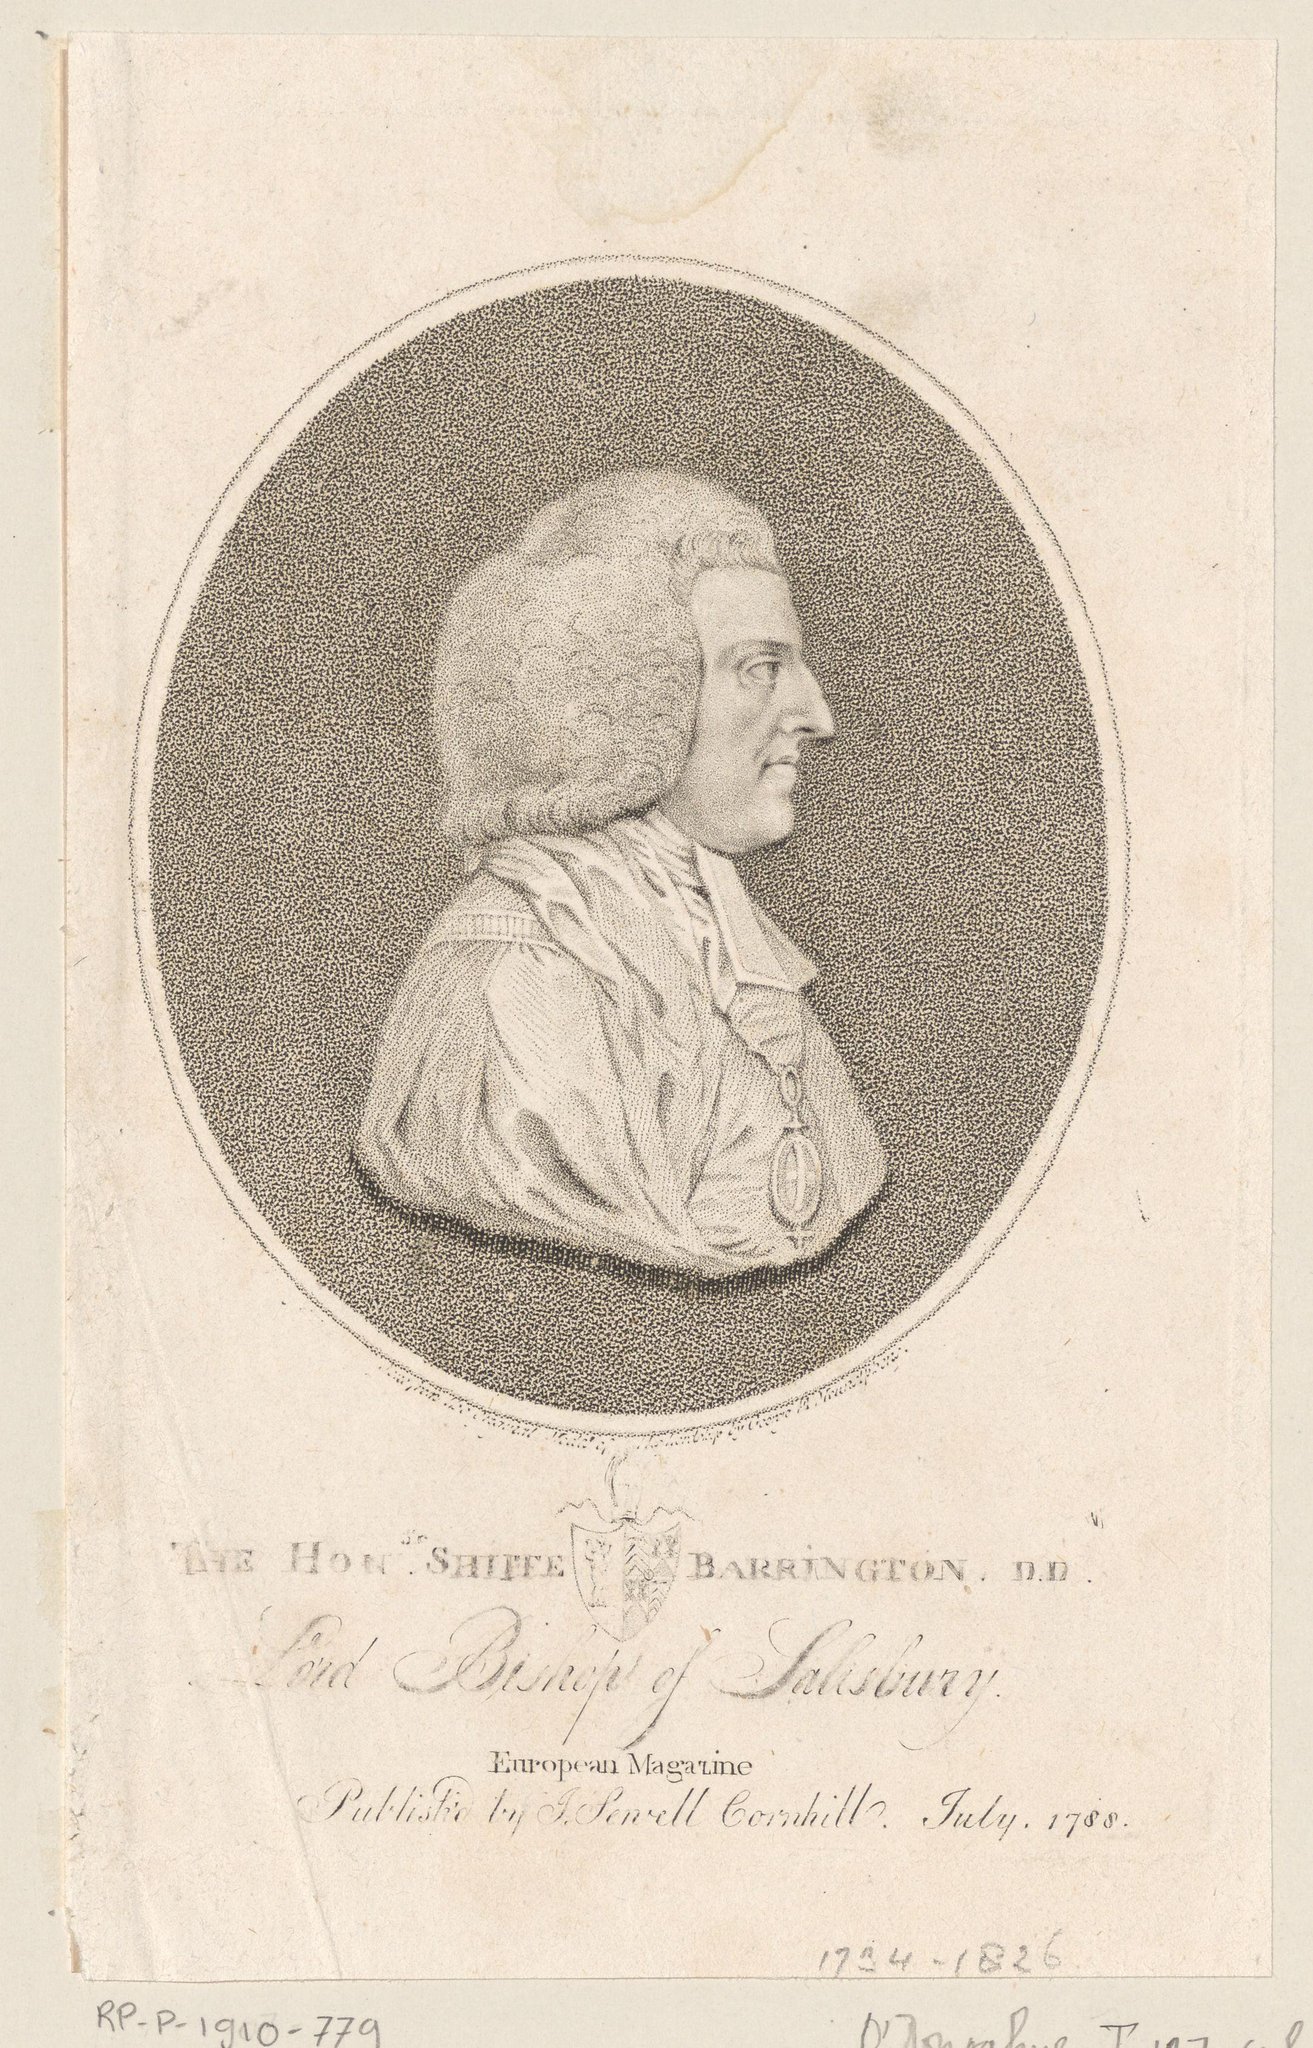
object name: print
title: Portret van Shute Barrington, bisschop van Salisbury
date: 1788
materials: paper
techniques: etching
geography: london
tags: historical persons, armorial bearing, heraldry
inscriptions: collector's mark: Lugt 2228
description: Prent uit: The European Magazine, and London Review 8 (1790), september 1790.